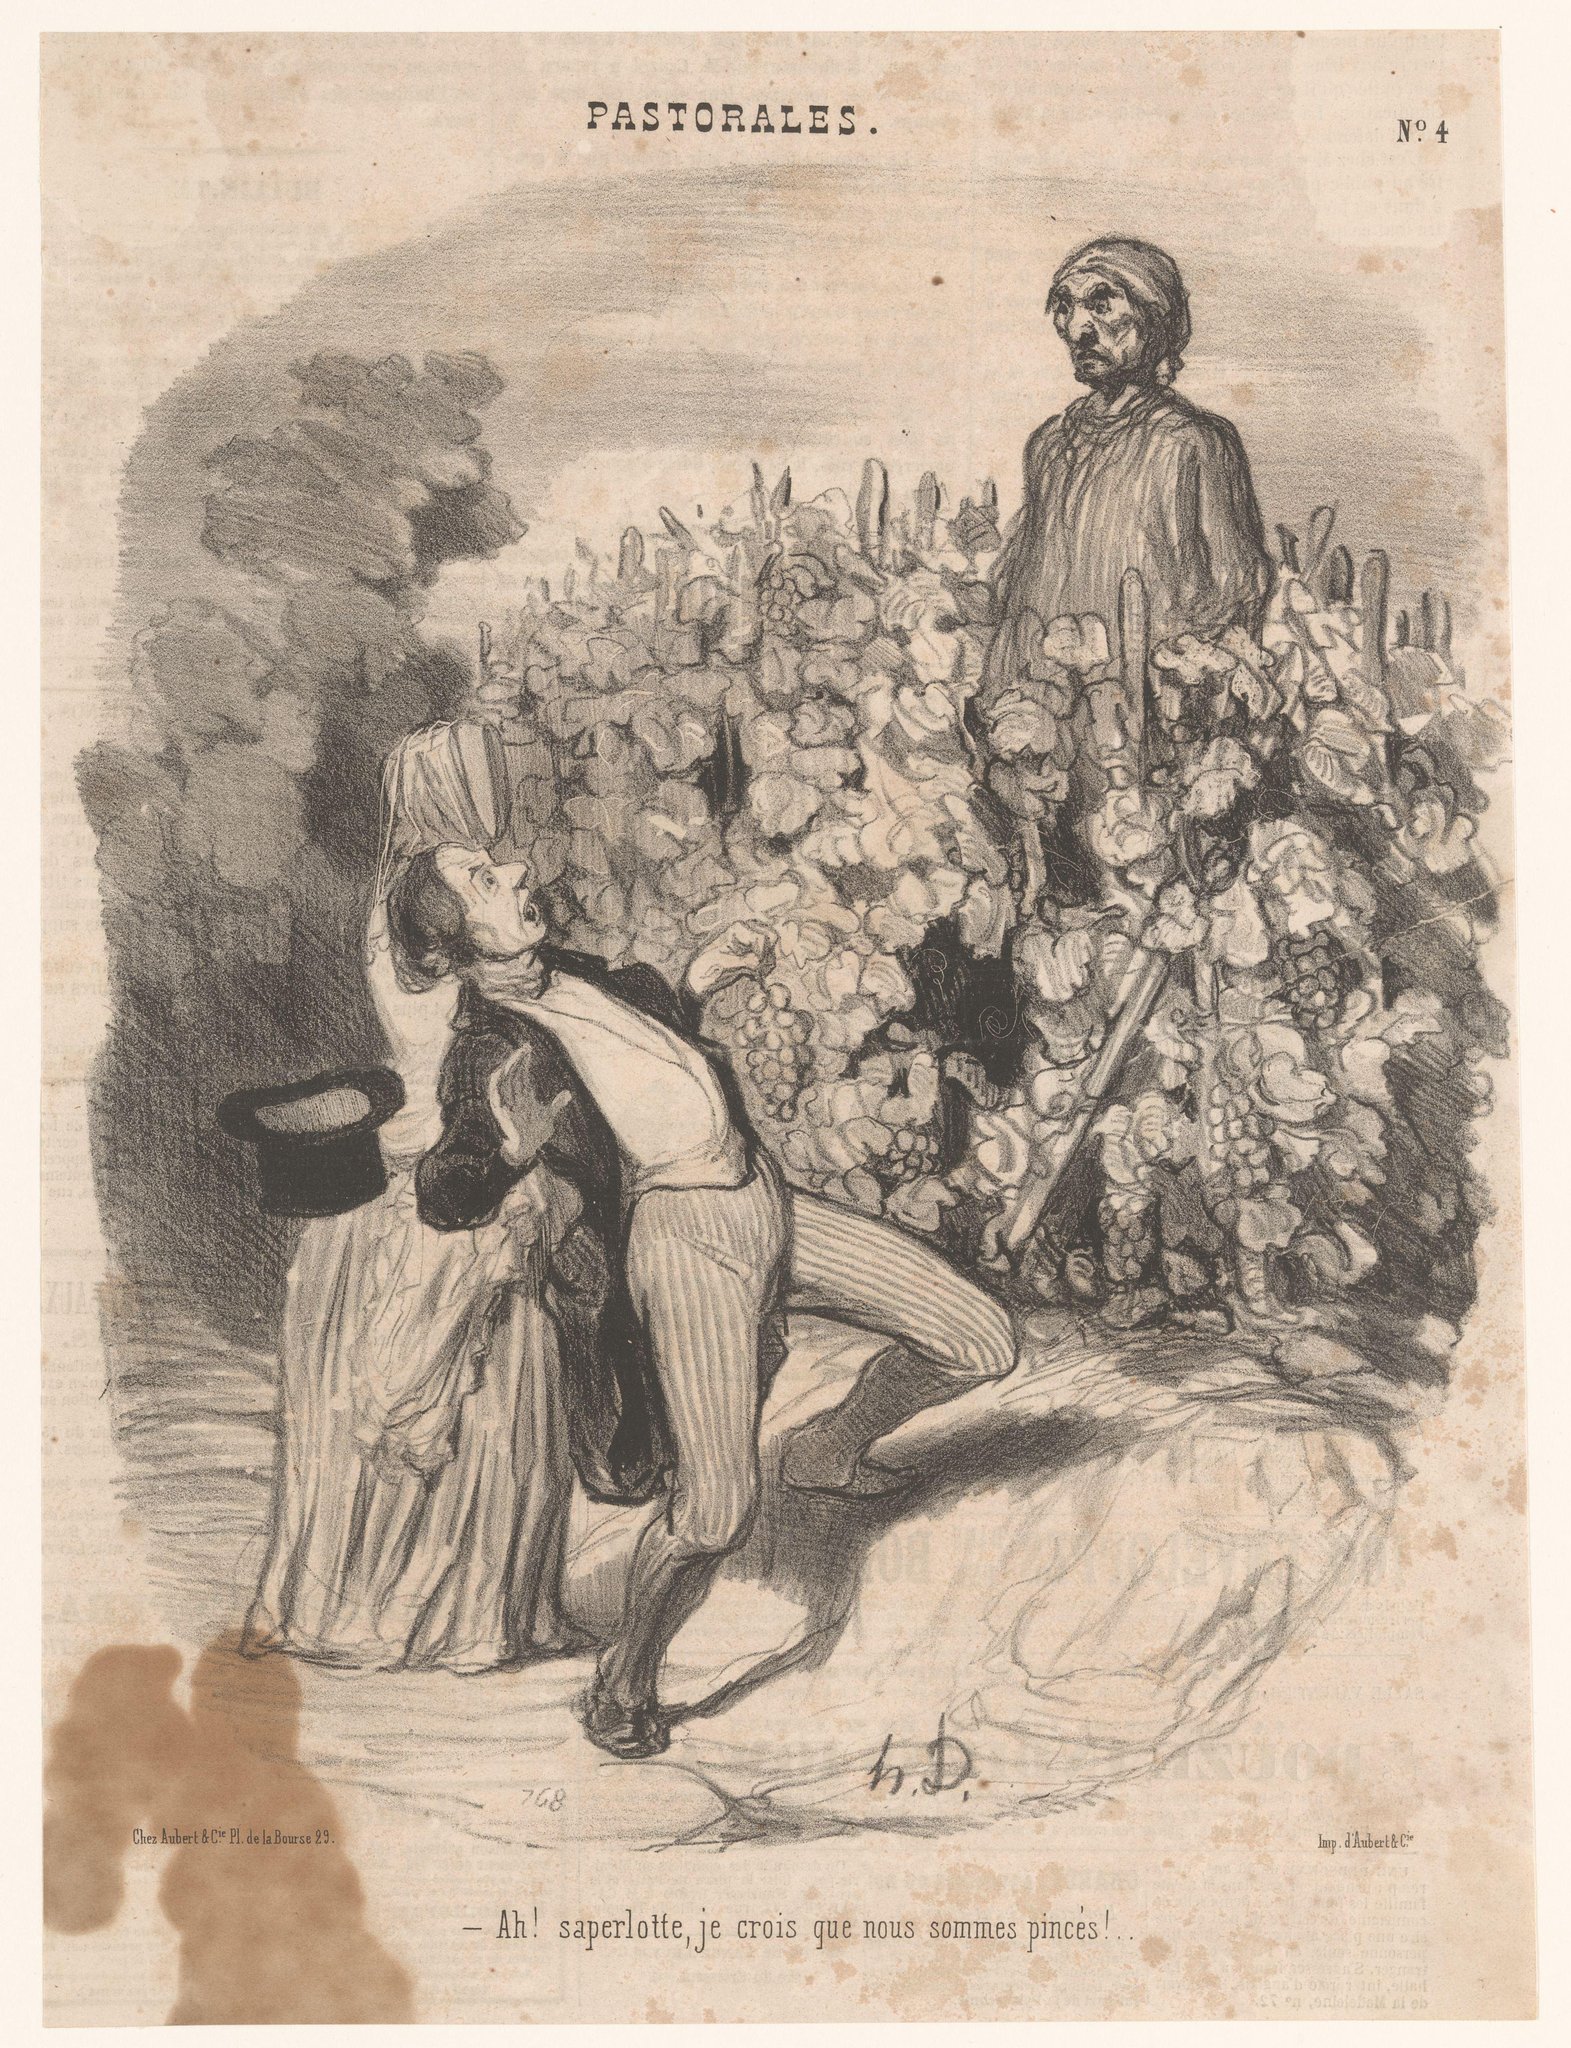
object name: cartoon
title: Voorstellingen van het platteland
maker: honoré daumier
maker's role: draughtsman, painter, print maker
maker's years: 1808-1879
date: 1845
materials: paper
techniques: lithograph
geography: paris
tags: alarm, fright; 'spavento', 'terrore' (ripa), vineyard, caricatures (human types)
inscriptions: collector's mark: Lugt 2228a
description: Prent gebruikt voor: Le Charivari, 08-06-1845.